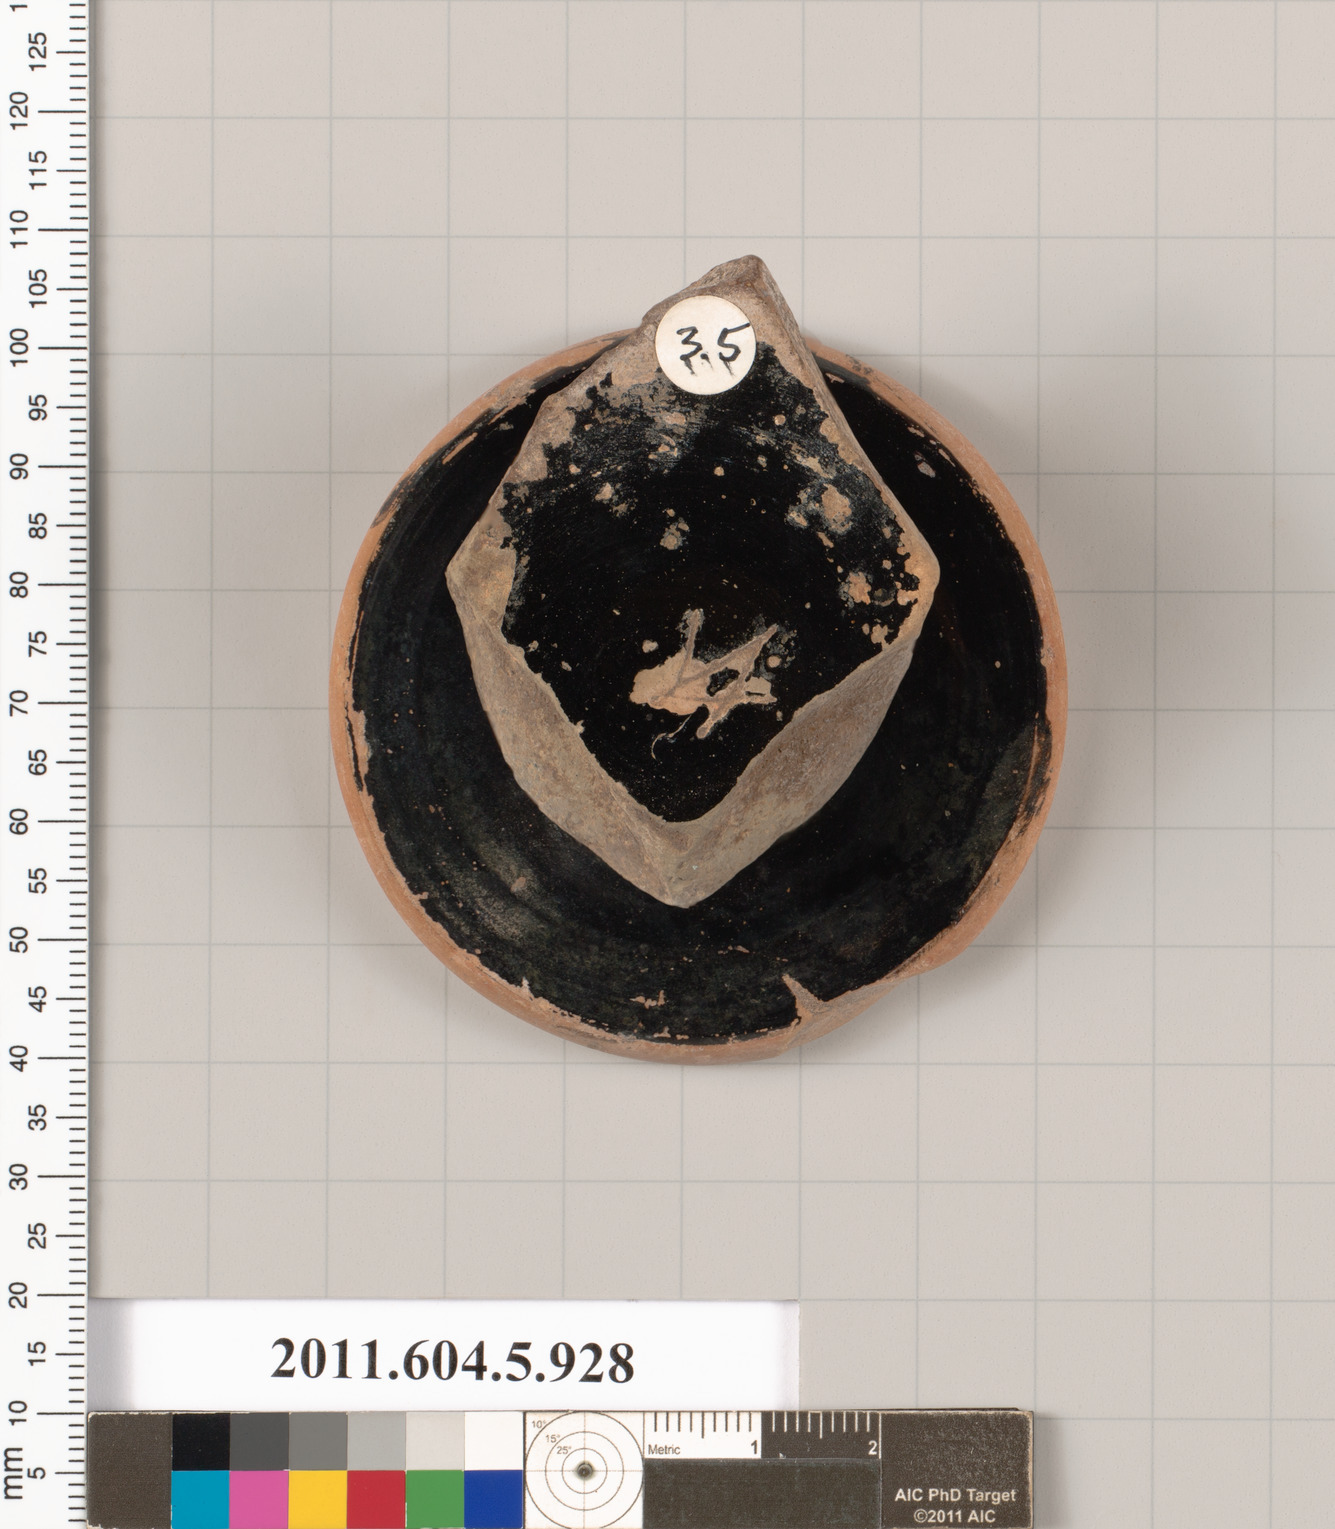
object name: kylix fragment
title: Terracotta fragment of a kylix (drinking cup)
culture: greek, attic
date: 600-401 BCE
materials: terracotta